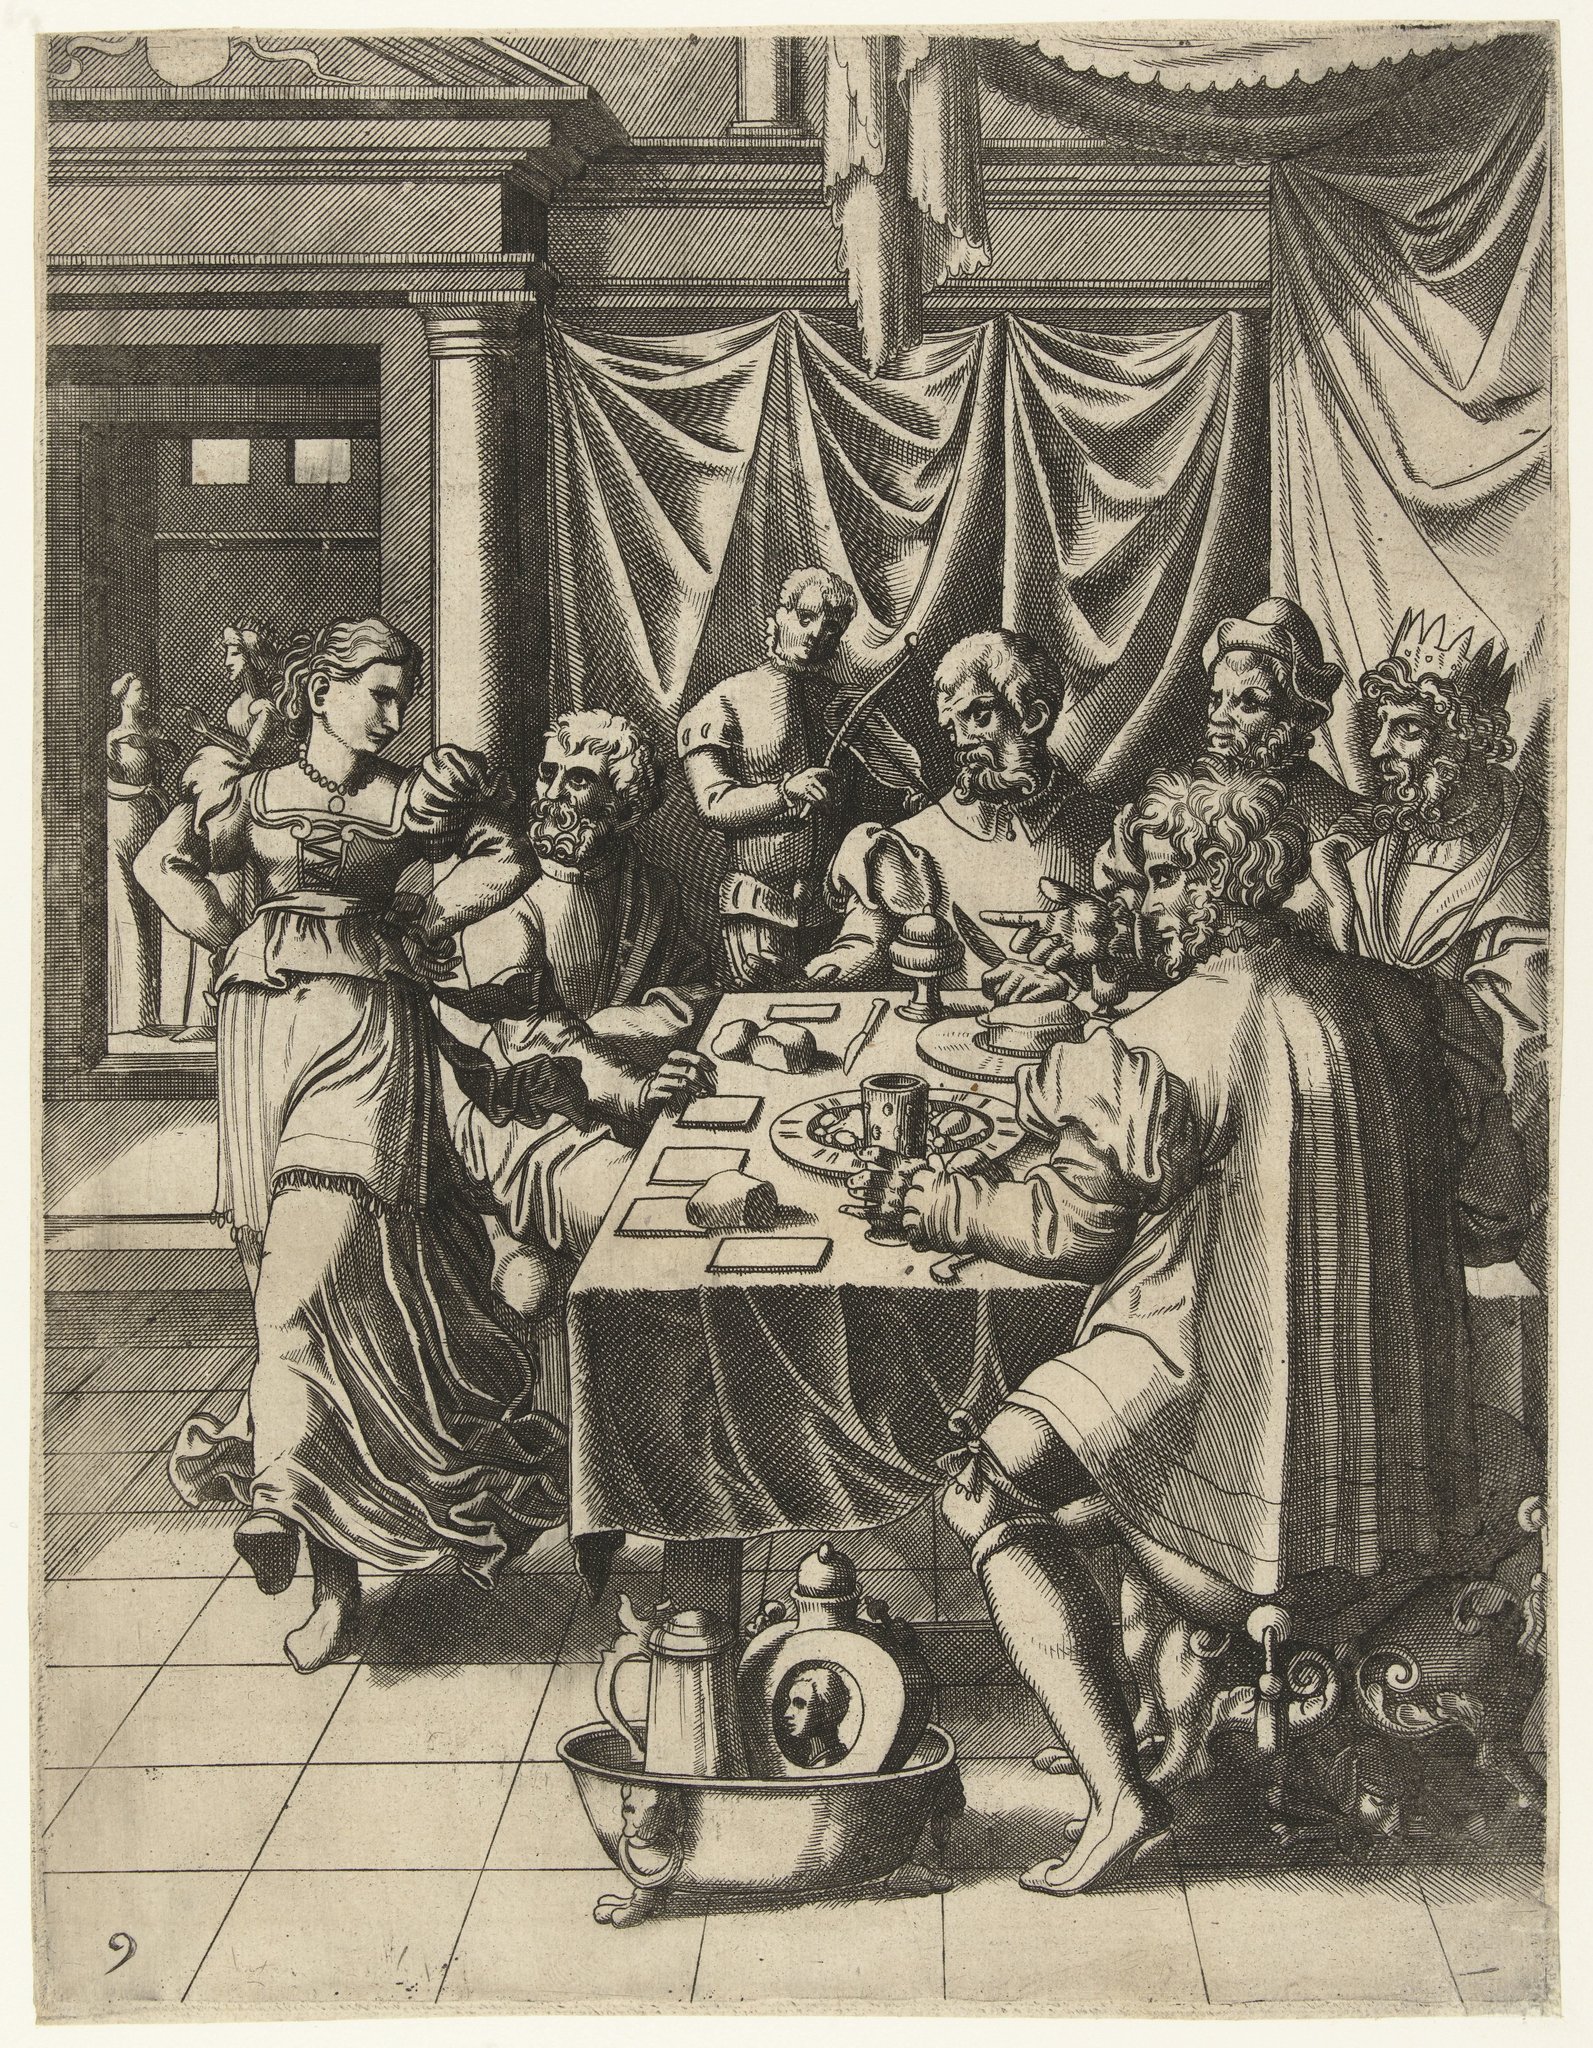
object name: print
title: Het leven van Johannes de Doper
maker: hans liefrinck (i)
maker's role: print maker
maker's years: 1518-1573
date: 1553-1558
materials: paper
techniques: etching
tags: herodias persuades salome to ask for the head of john the baptist, salome dancing during the banquet of herod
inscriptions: collector's mark: Lugt 2228a, collector's mark: Lugt 2760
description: Koning Herodes met mannen aan tafel. Salomé dans voor hem. Achterin de ruimte opnieuw Salomé, nu in gesprek met Herodias.